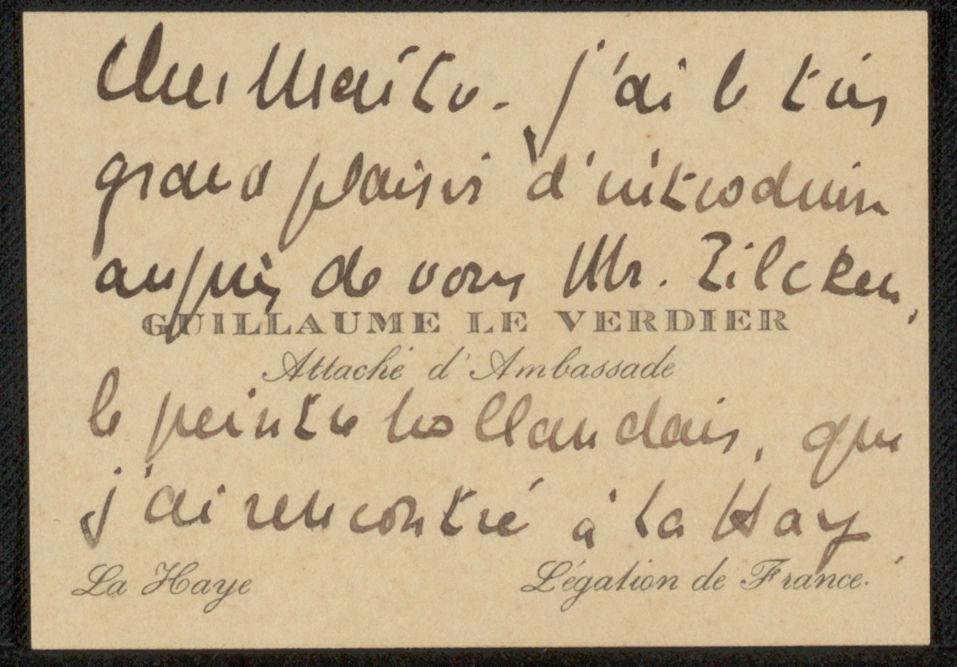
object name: visiting card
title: Visitekaartje aan Jean de Resgré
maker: guillaume le verdier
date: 1867-1930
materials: ink, paper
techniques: pen, printing, writing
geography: the hague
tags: the hague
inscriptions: collector's mark: ‘RPK’